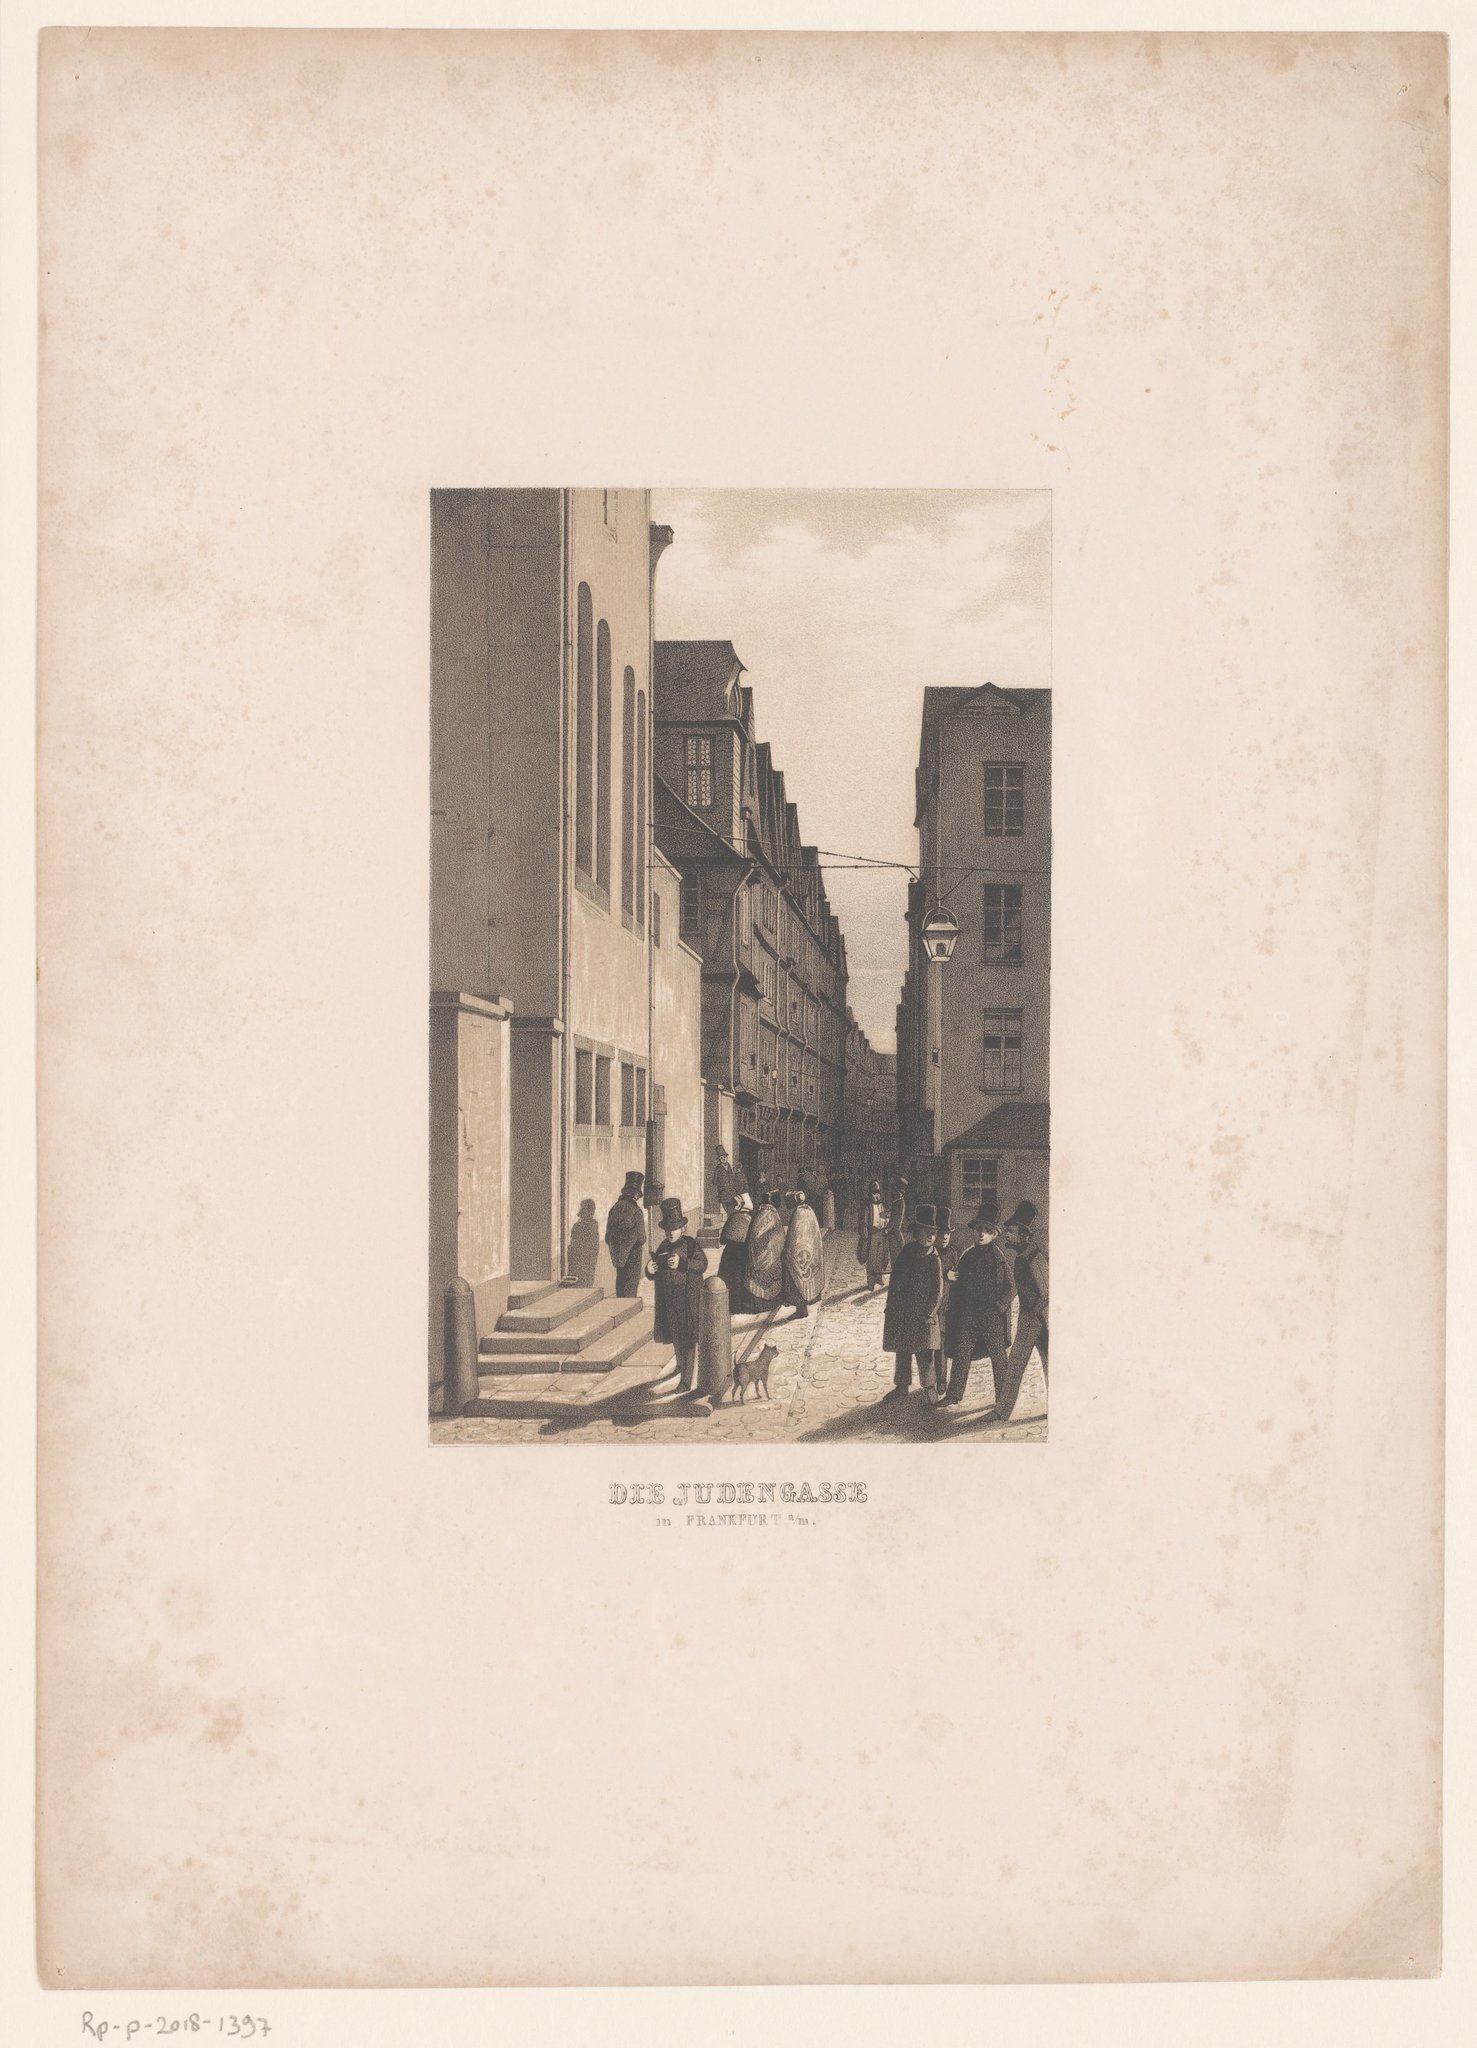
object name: print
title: Die Judengasse in Frankfurt a/m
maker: Anonymous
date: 1800-1899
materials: paper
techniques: lithograph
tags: ghetto ~ anti-semitism, street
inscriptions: collector's mark: Lugt 2228